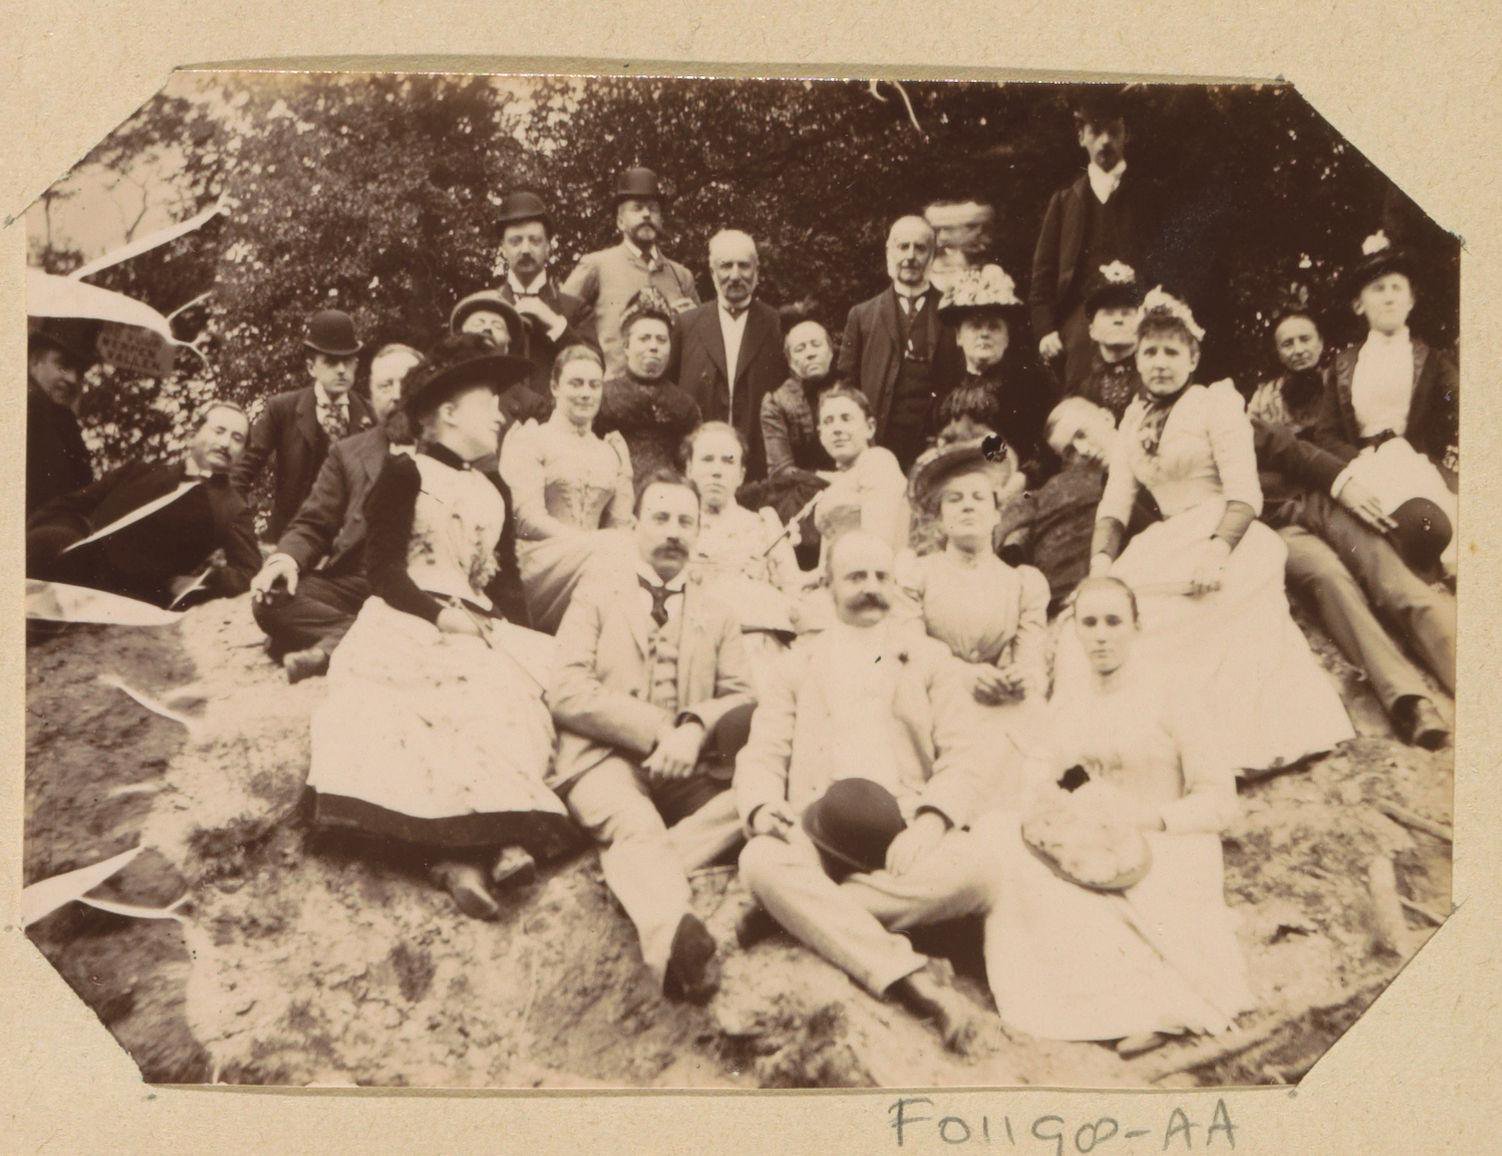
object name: photograph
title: Groepsportret van de familie Piek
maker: johanna margaretha piek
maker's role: fotograaf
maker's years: 1870-1947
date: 1889-1893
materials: paper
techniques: gelatin silver print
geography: netherlands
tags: family life, anonymous historical persons portrayed in a group, in a group-portrait, netherlands